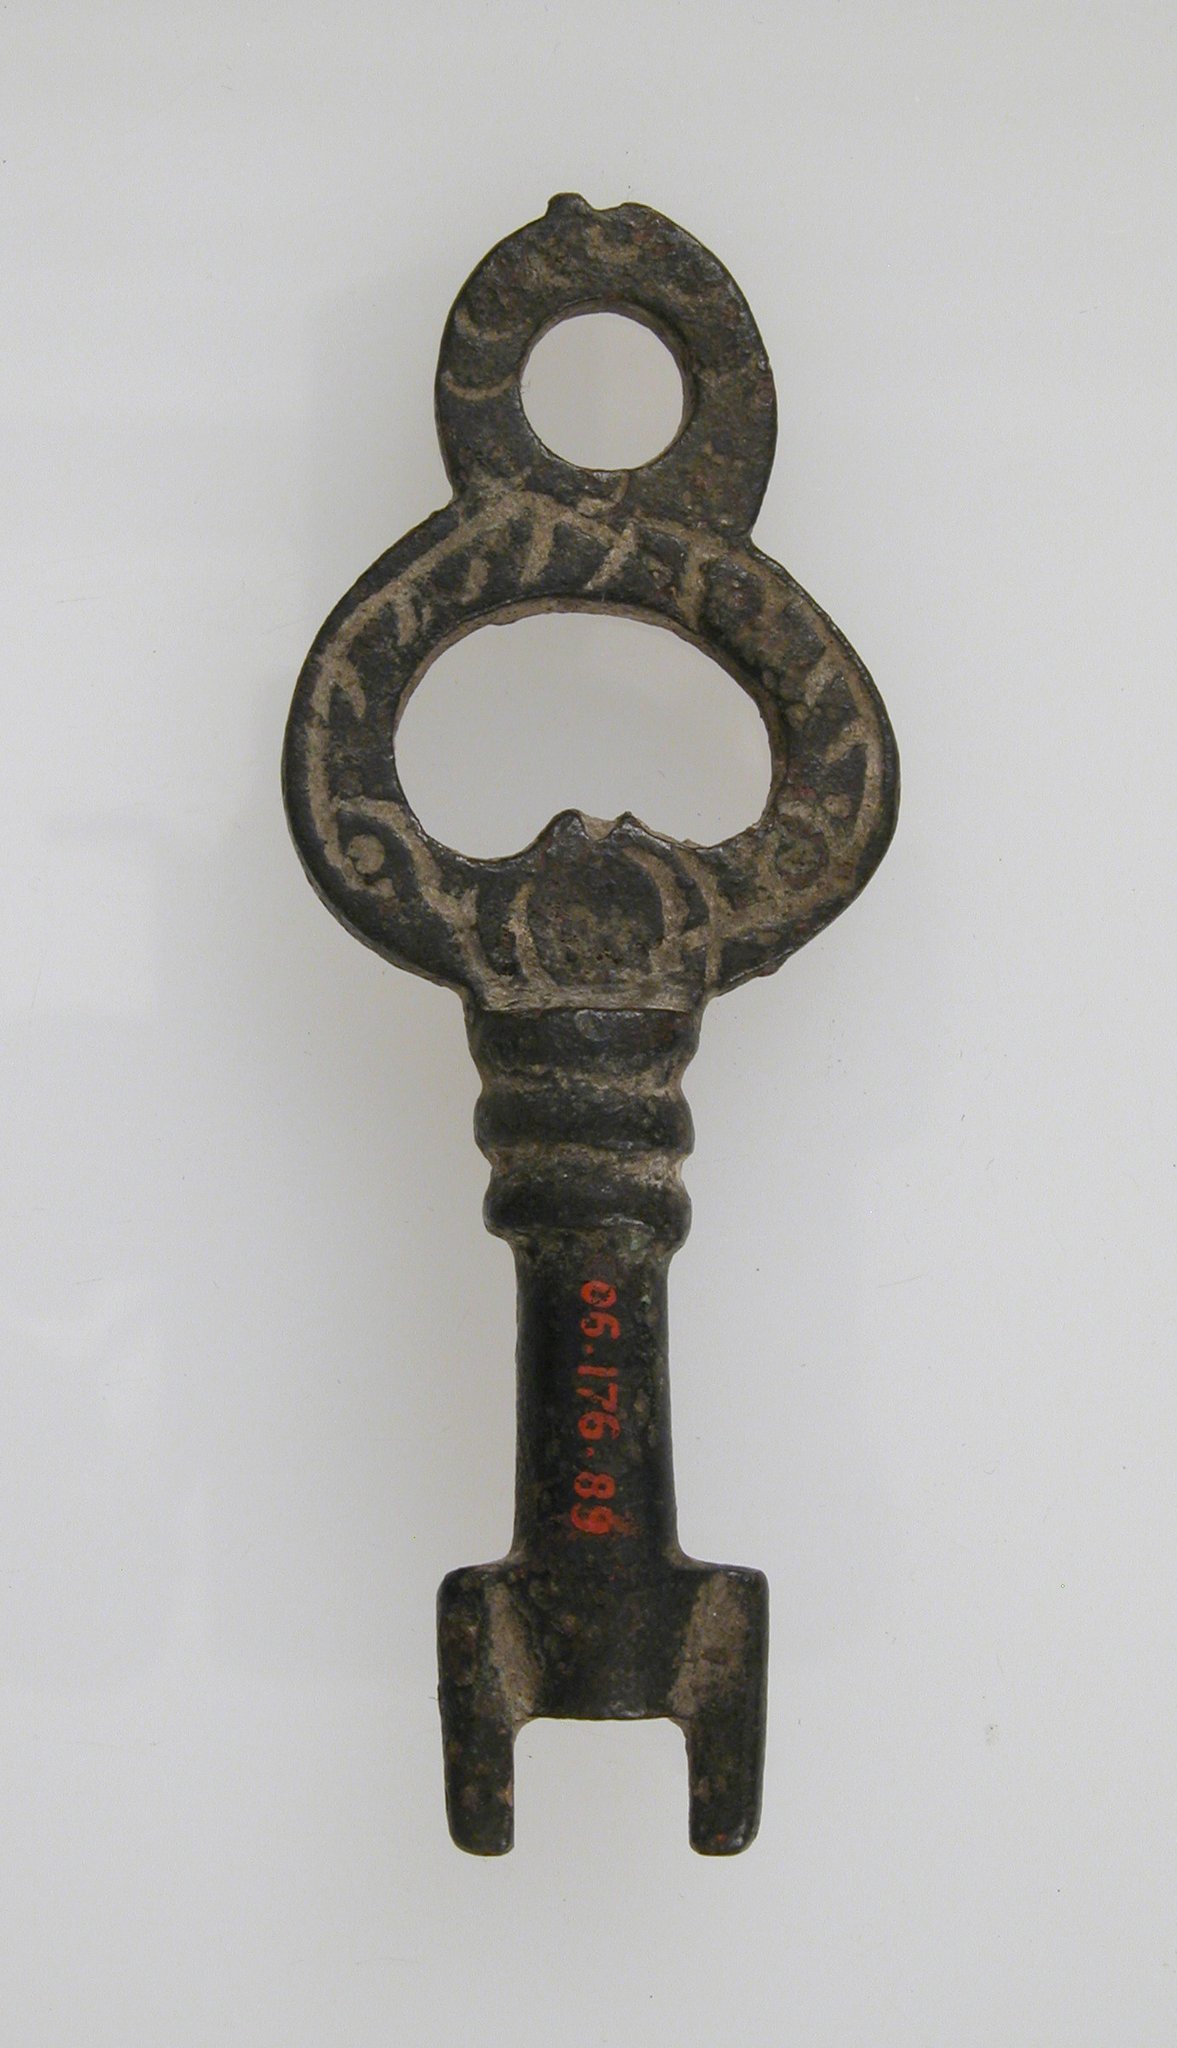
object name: key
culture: roman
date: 1-700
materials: copper alloy